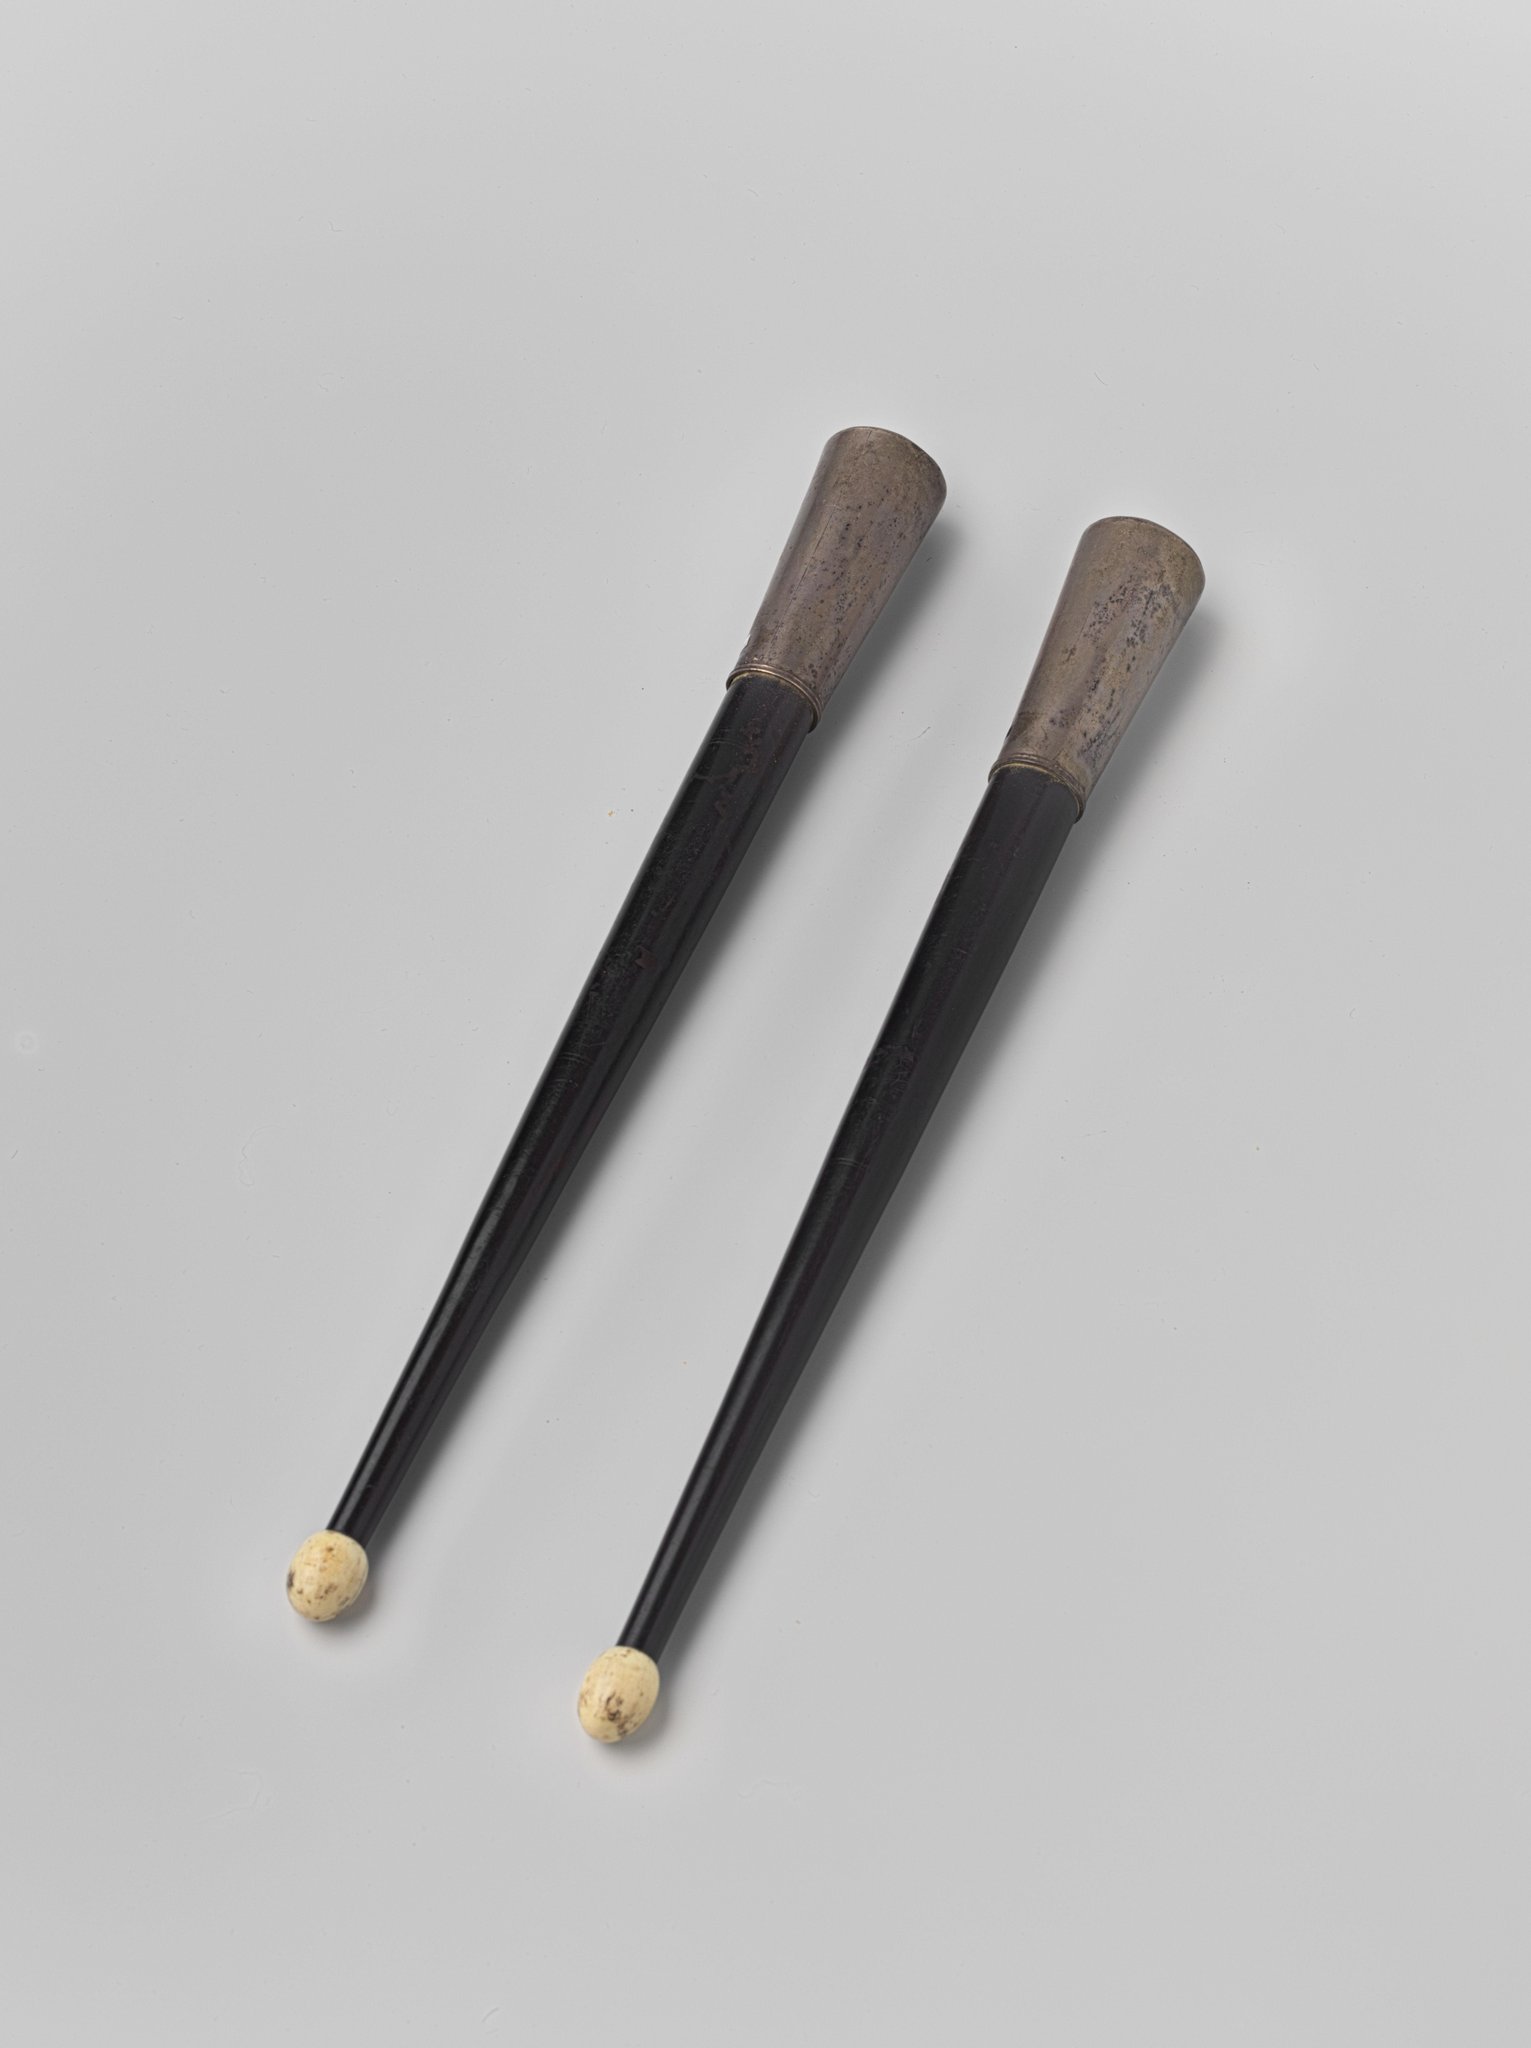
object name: musical instrument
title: Drumsticks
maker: Anonymous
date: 1817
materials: wood, ivory, silver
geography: netherlands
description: Een ebbenhouten tromstok met ivoren knop.